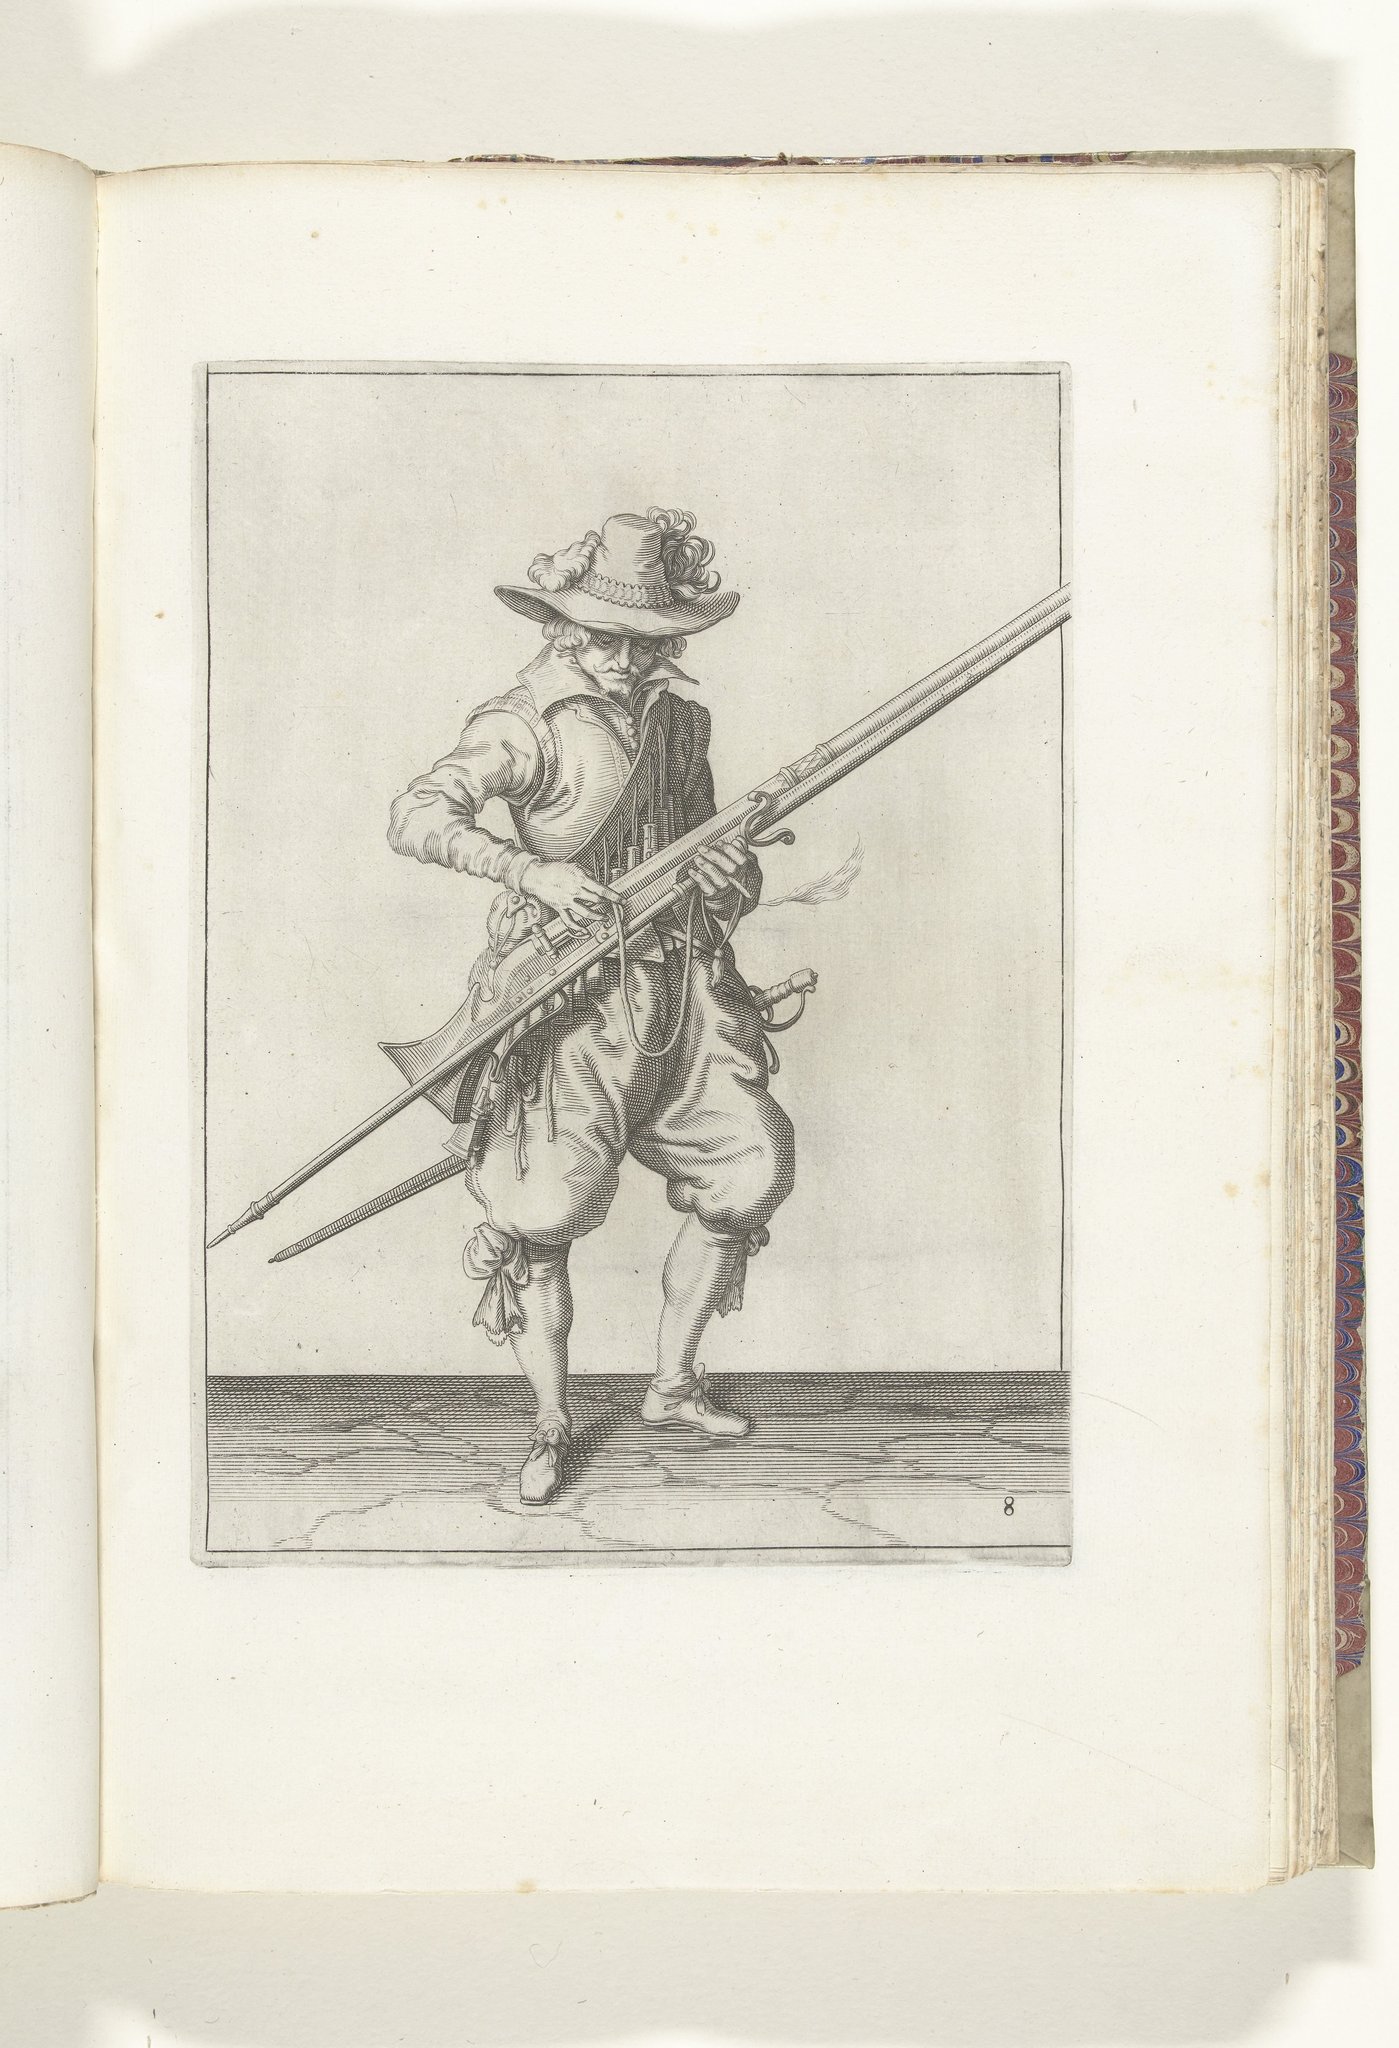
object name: print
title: Soldaat die zijn lont op de haan van zijn musket drukt (nr. 8), ca. 1600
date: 1597-1607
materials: paper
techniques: engraving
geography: northern netherlands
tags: maurice (prince of orange), handling of weapons ~ military training, weapons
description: Een soldaat, ten voeten uit, naar rechts, die een musket (een bepaald type vuurwapen) met zijn linkerhand vasthoudt (nr. 8), ca. 1600. Met zijn rechterhand drukt hij een brandende lont op de haan (onderdeel van het ontstekingsmechanisme) van zijn musket. Plaat 8 in de instructies voor het hanteren van het musket: Corte onderrechtinghe op de figuerlicke afbeeldinghe, soo veel aengaet het recht ghebruyck van Musquet. Onderdeel van de illustraties in: J. de Gheyn, Wapenhandelinghe van Roers Musquetten ende spiessen, Amsterdam, 1608. Krijgswezen rond 1600.